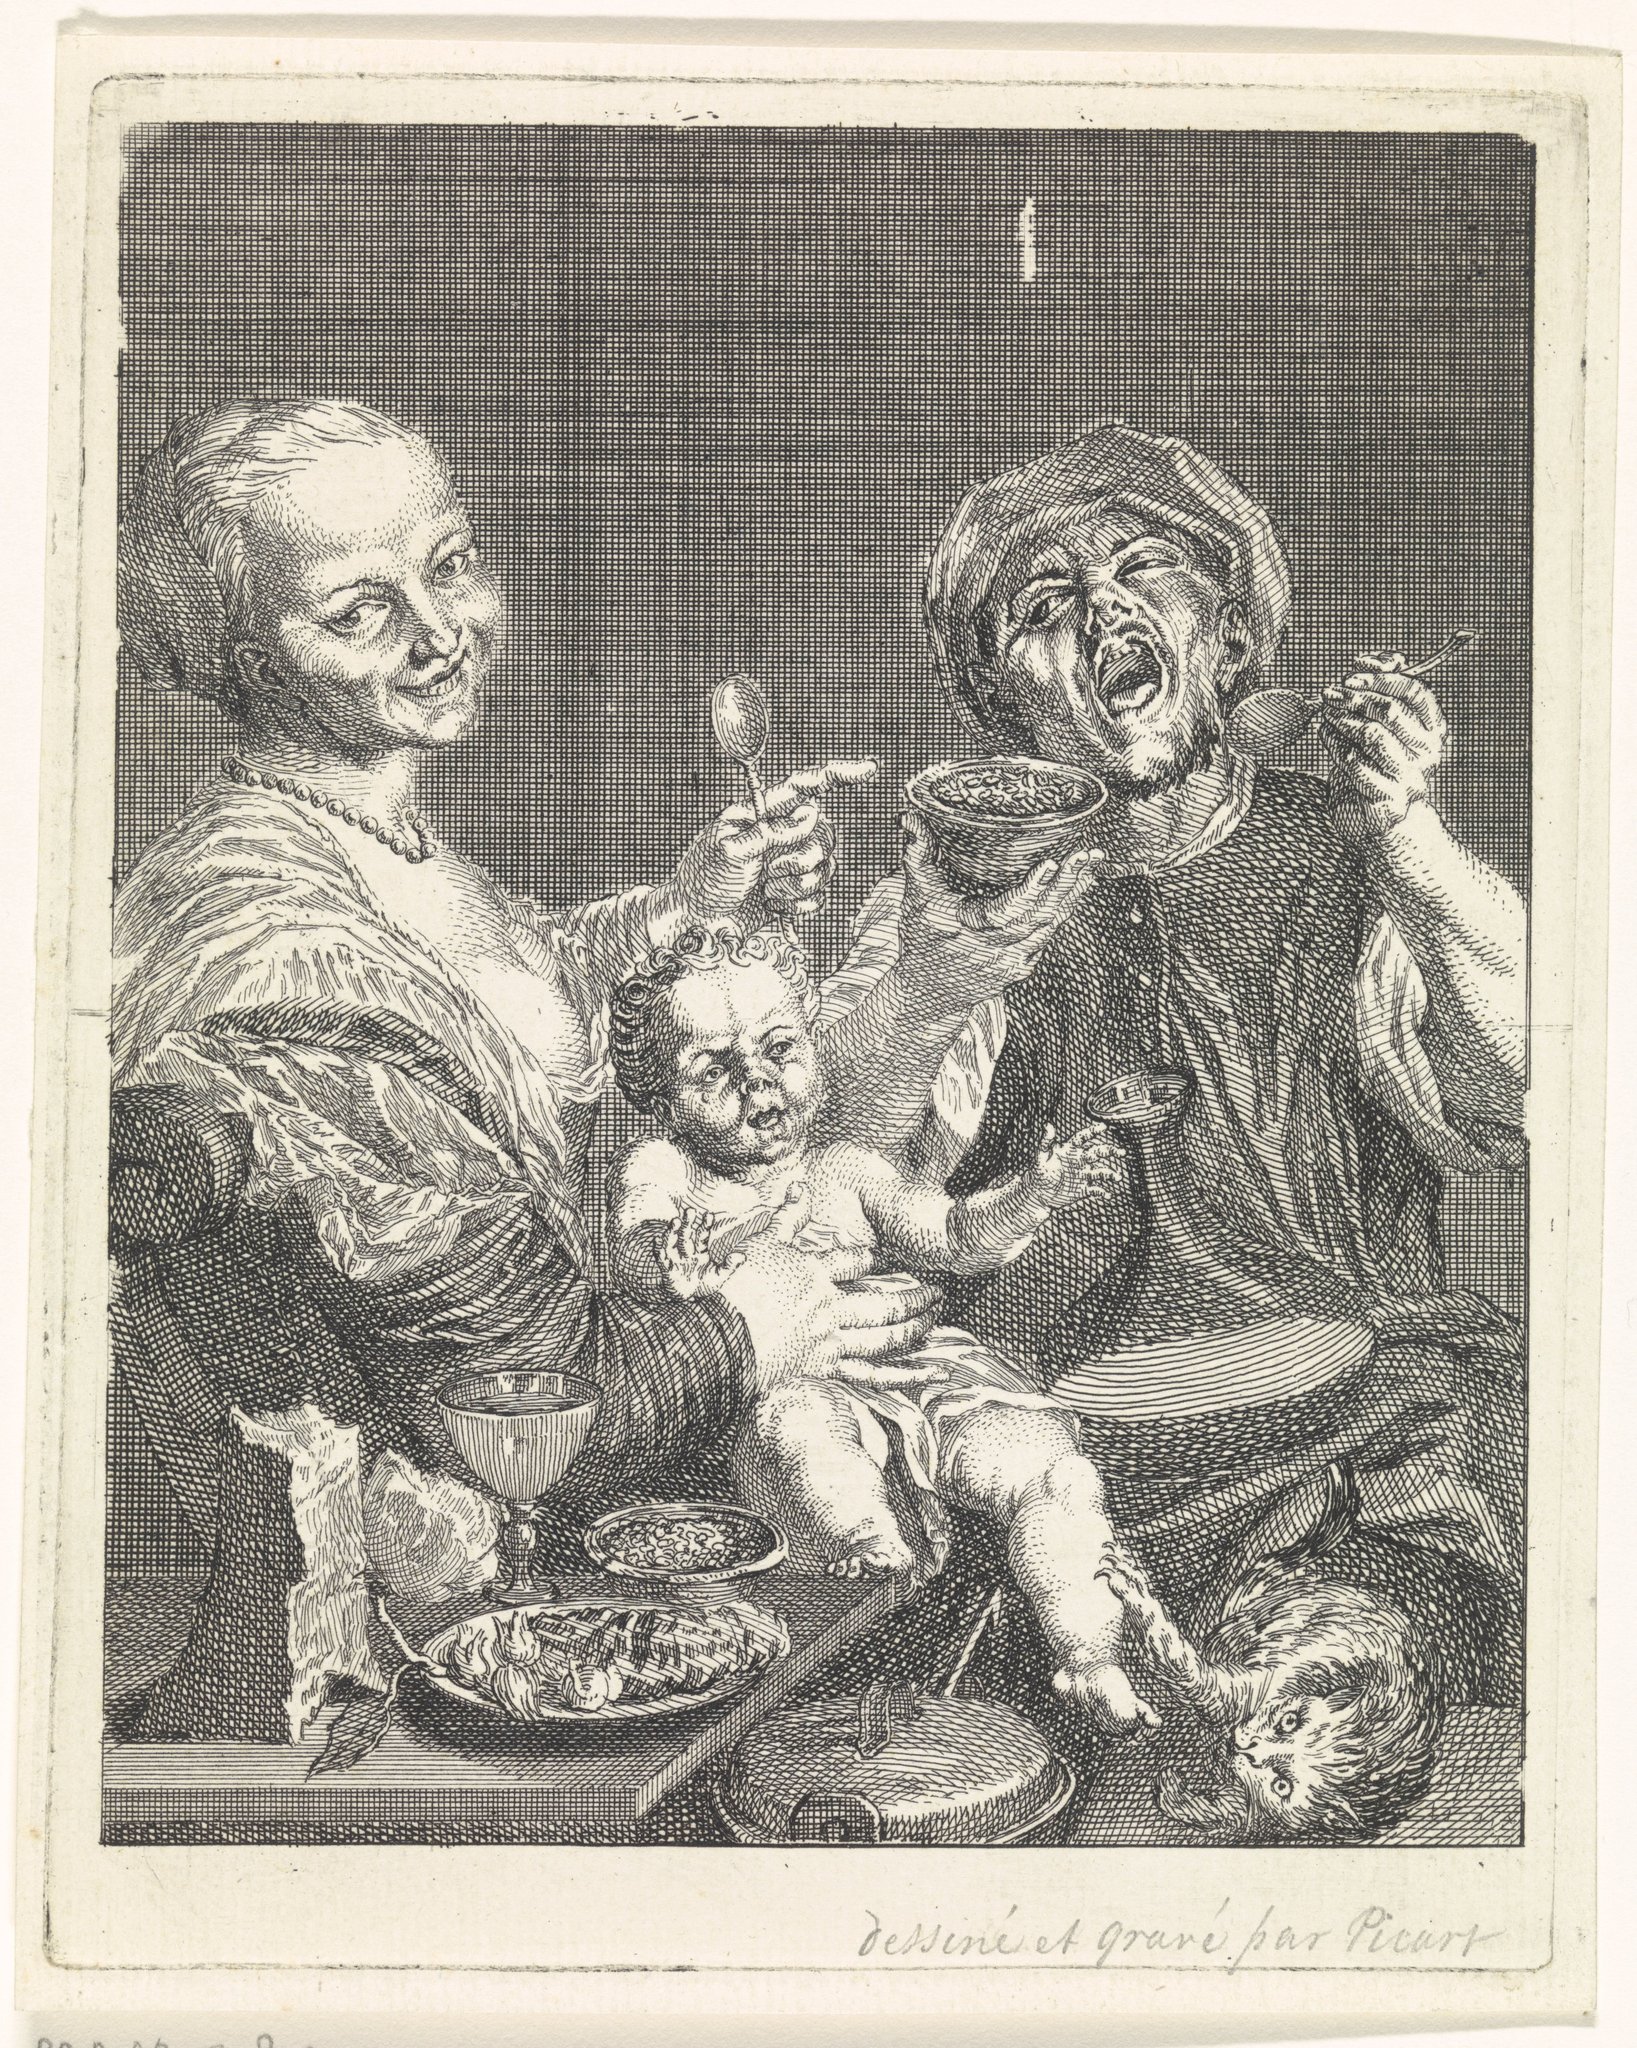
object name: print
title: Gezin aan de maaltijd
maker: bernard picart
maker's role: draughtsman, print maker, publisher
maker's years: 1673-1733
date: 1683-1733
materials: paper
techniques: etching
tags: seed: pea, cat, (family) meal, eating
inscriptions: collector's mark: Lugt 2228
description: Definitieve genummerde staat van deze prent opgenomen in: Impostures innocentes, ou recueil d'estampes d'apres divers peintres (...) par Bernard Picart (...) avec son elogue historique et le catalogue de ses ouvrages. Amsterdam: weduwe Bernard Picart, 1734.